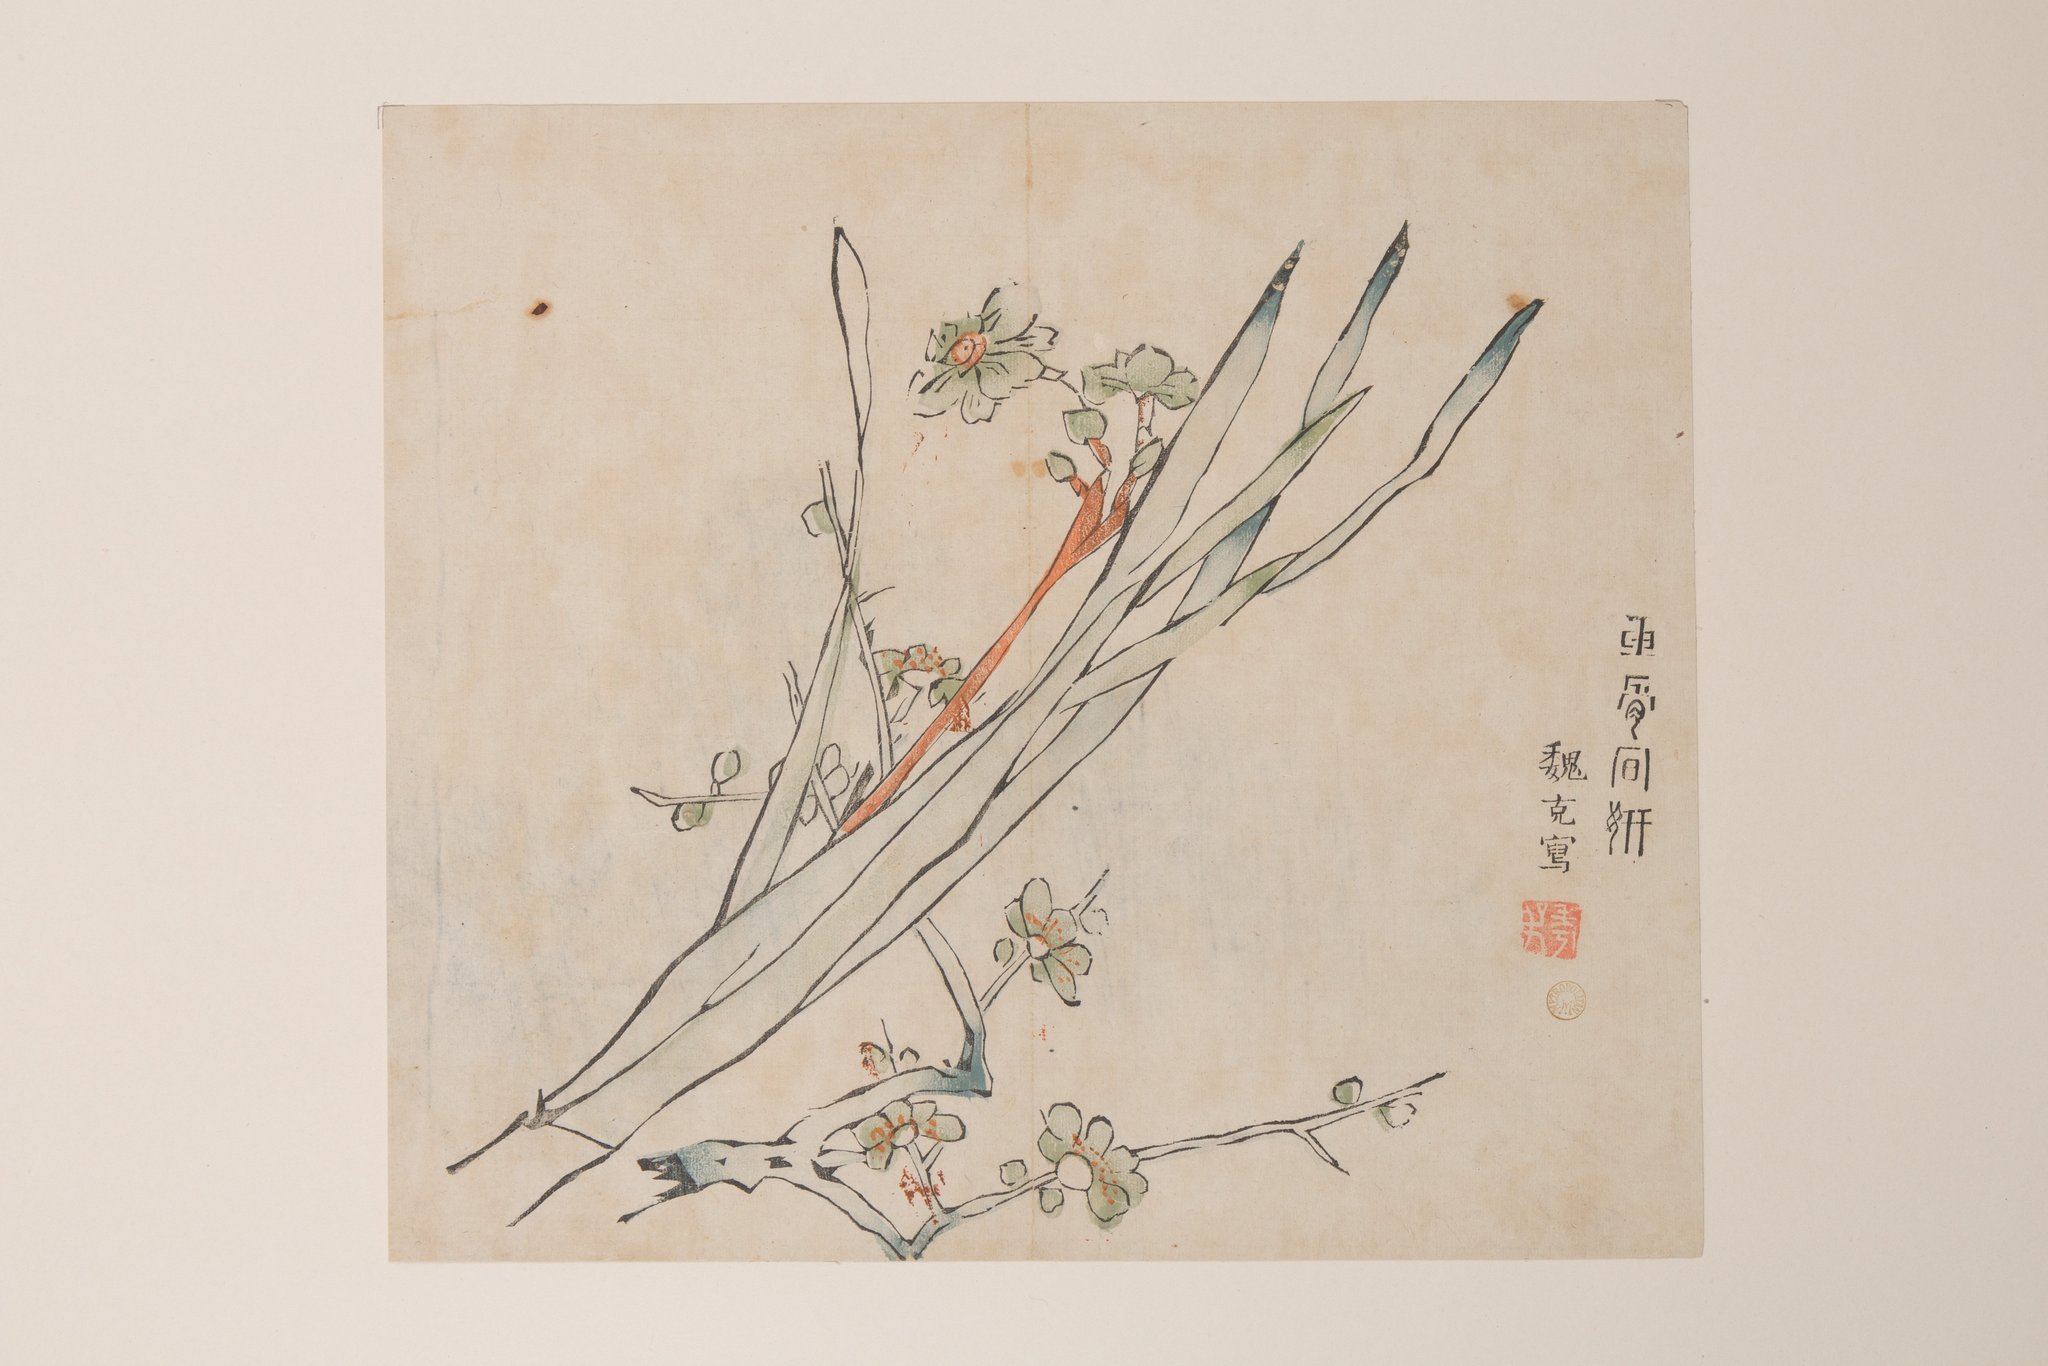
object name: print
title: Page from Shi Zhu Zhai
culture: chinese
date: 1662-1722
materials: ink, paper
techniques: polychrome, woodblock print